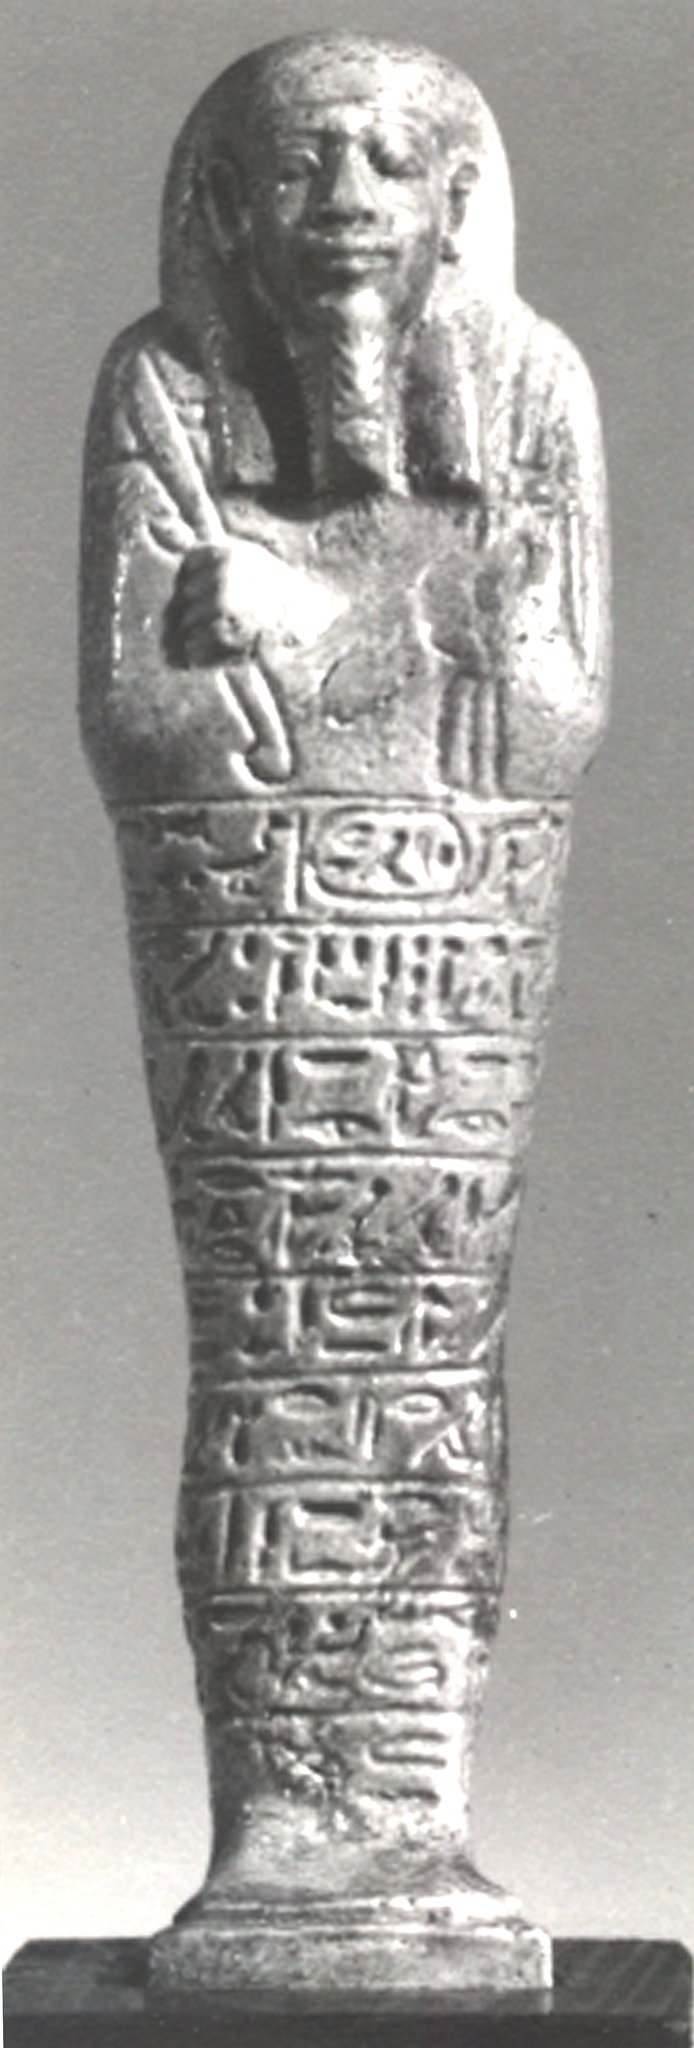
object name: shabti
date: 688-525 BCE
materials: faience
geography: egypt